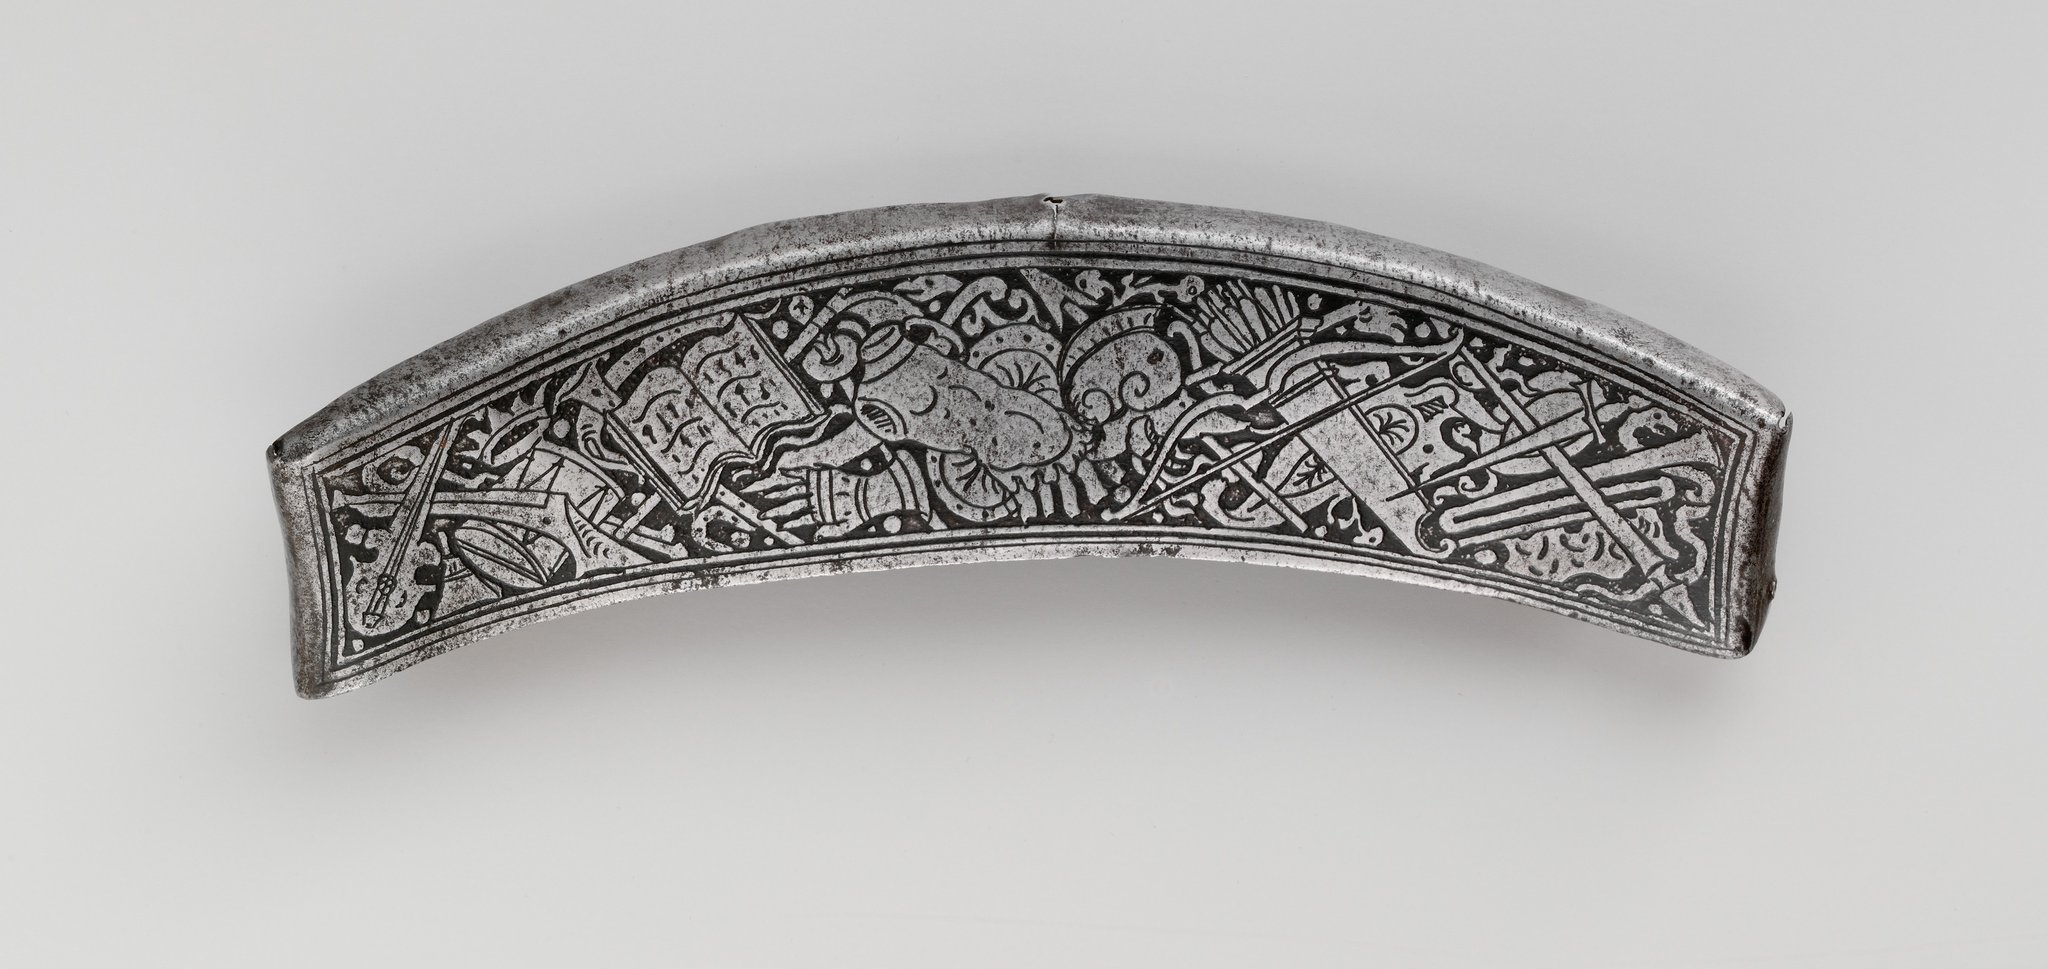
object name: pommel plate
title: Inner Pommel Plate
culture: italian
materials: steel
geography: italy